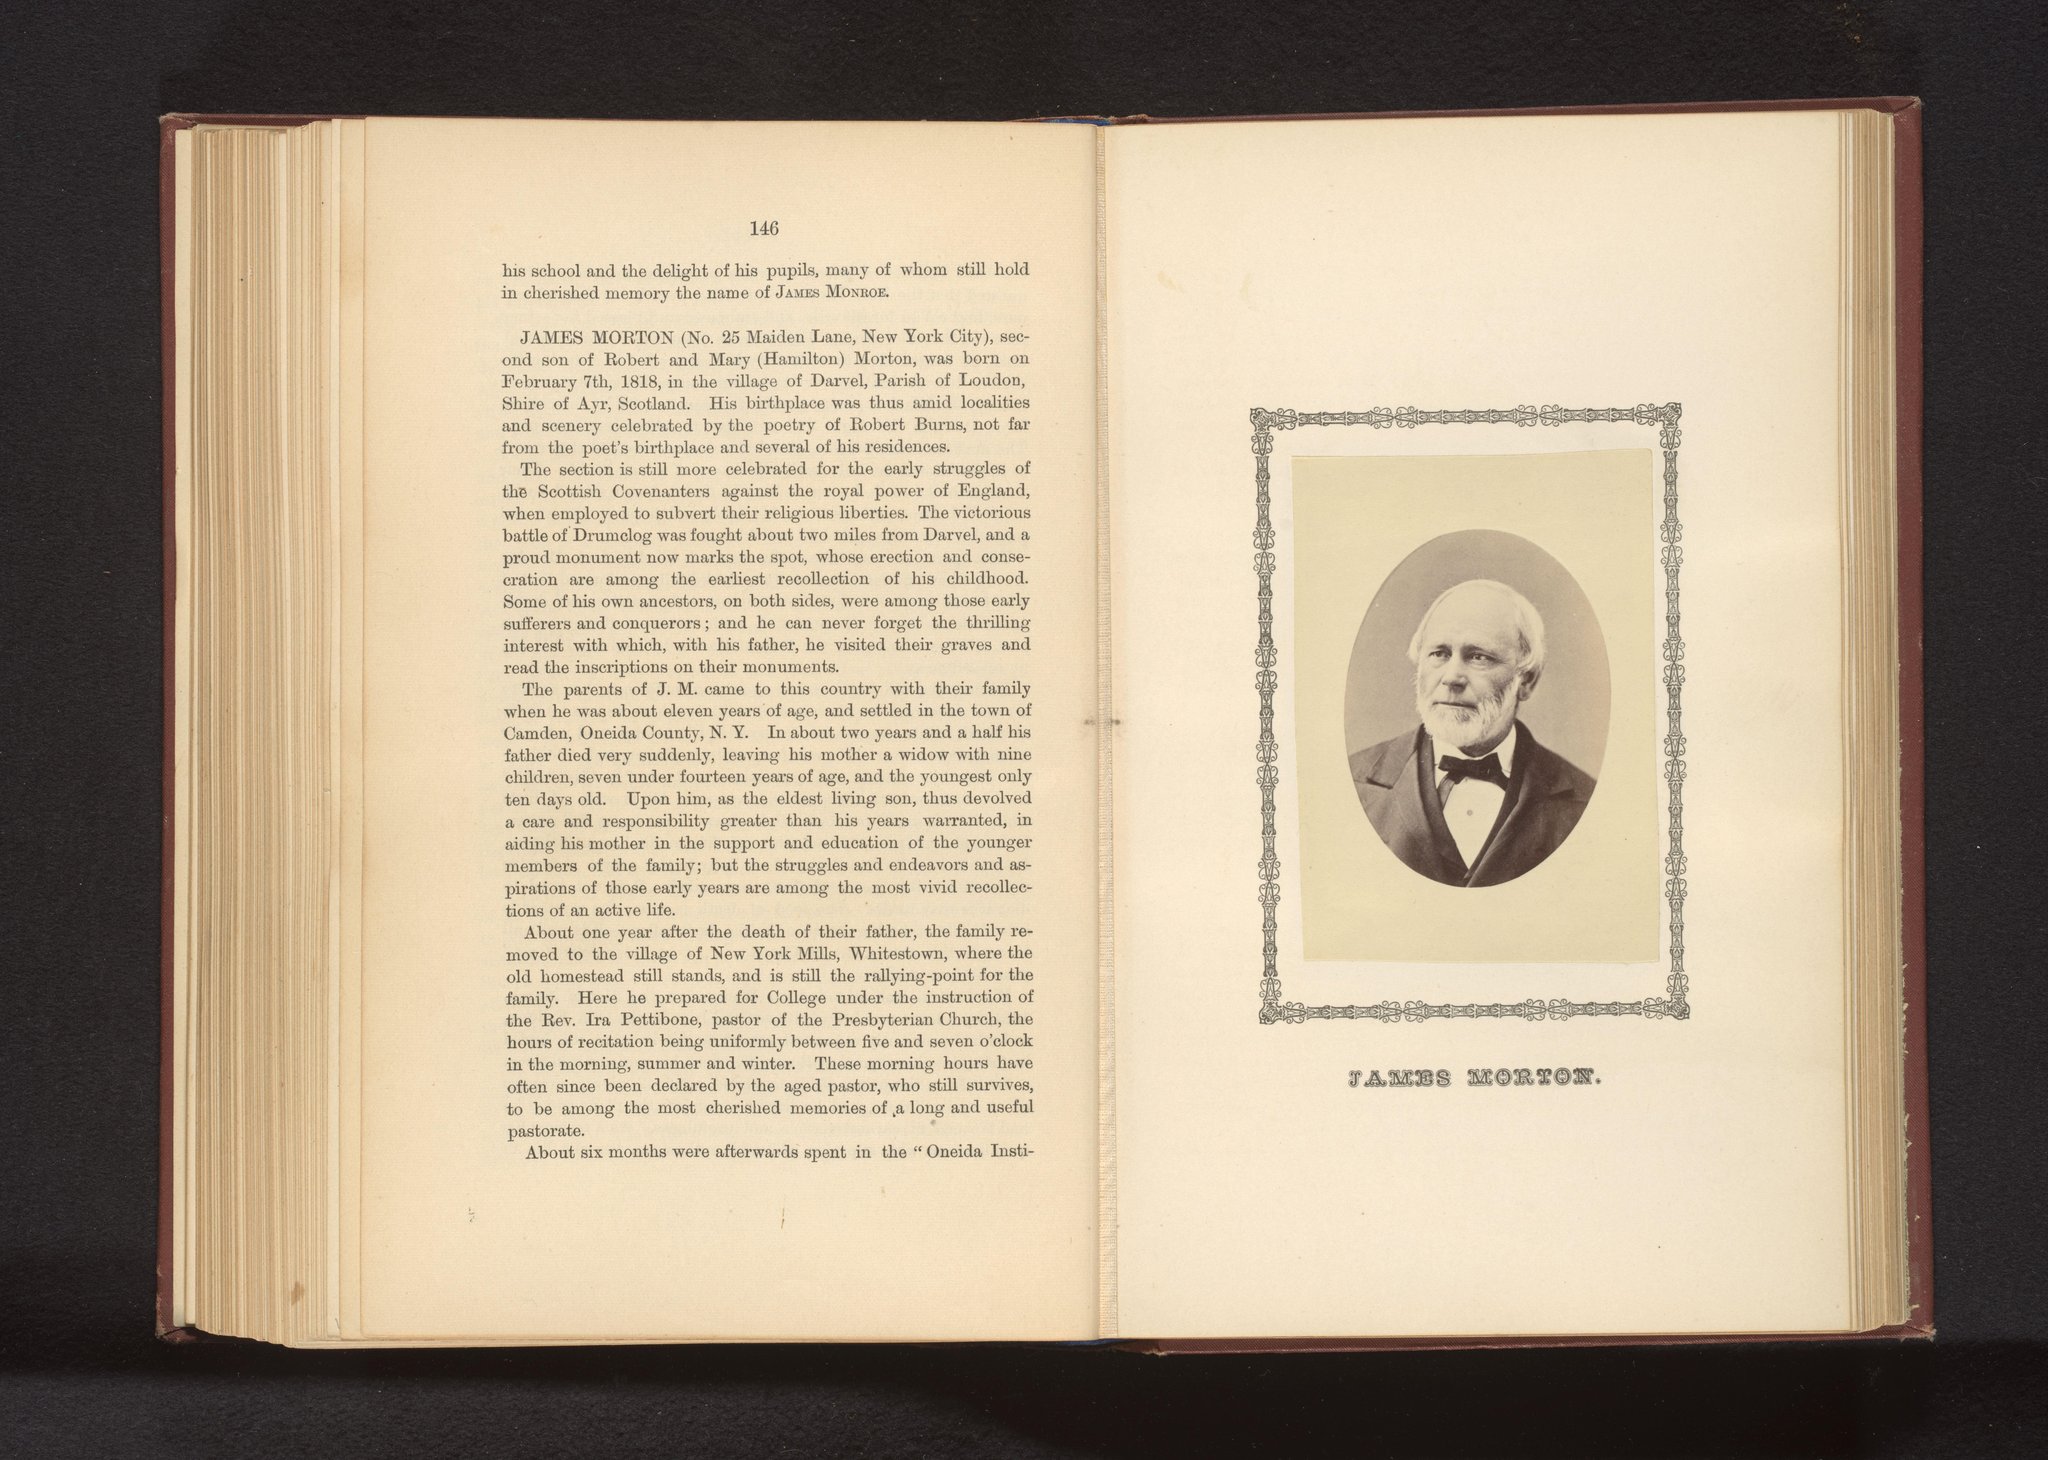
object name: page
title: James Morton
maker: Anonymous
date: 1876-1881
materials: photographic support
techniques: albumen print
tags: adult man